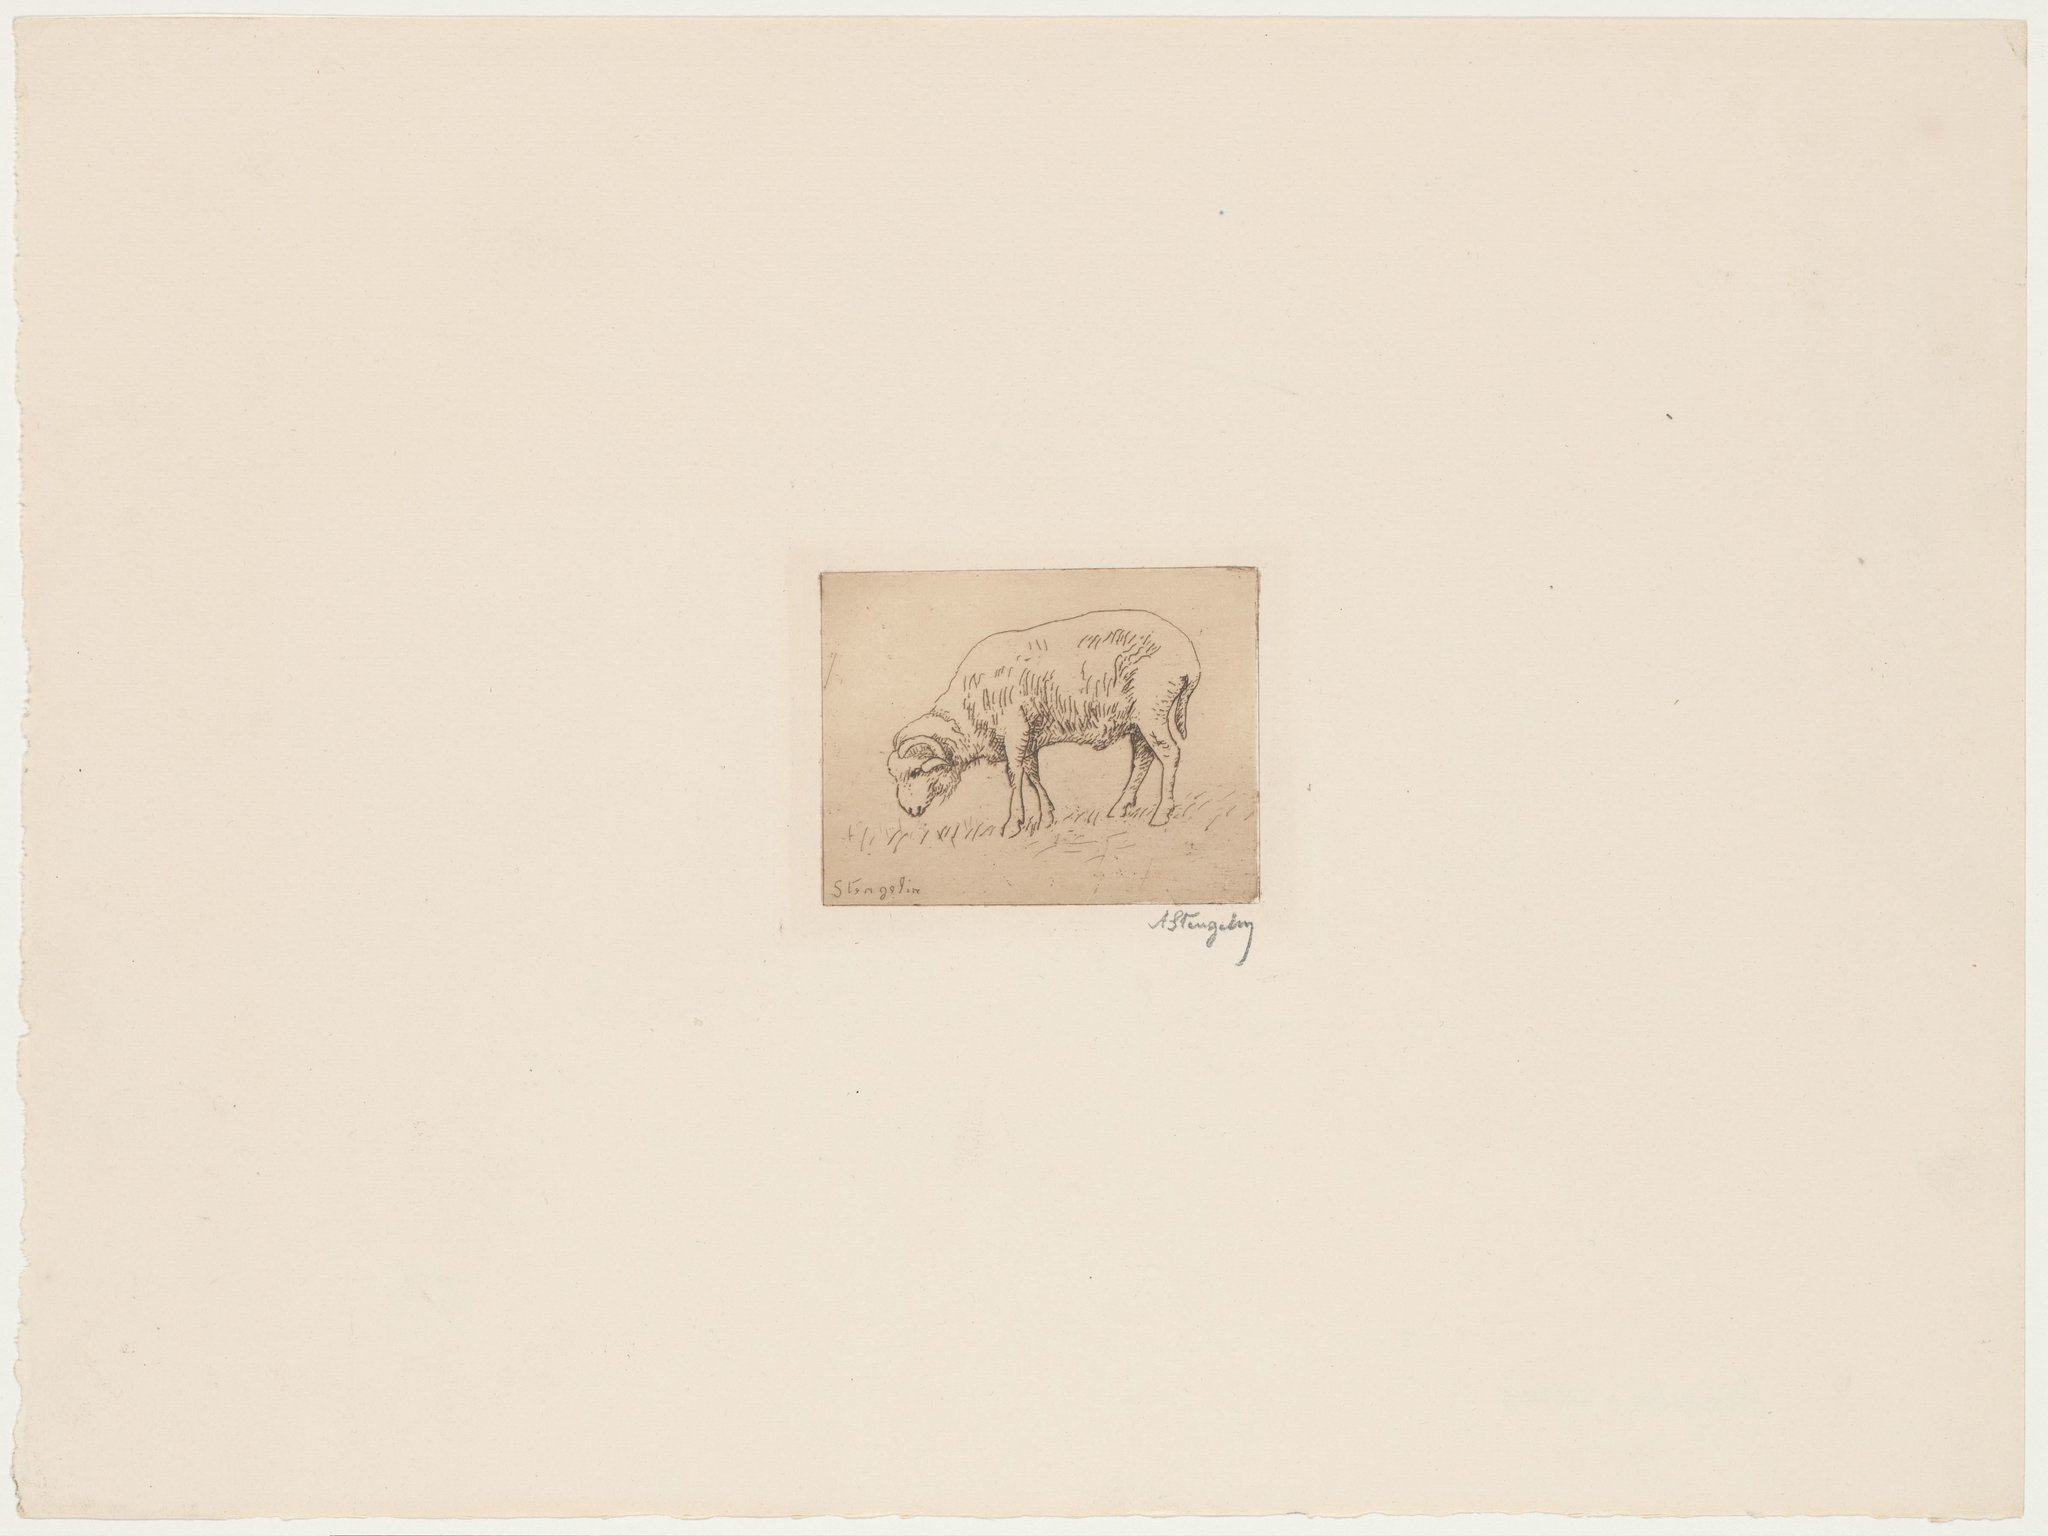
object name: print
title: Studie van een ram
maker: alphonse stengelin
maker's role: painter, print maker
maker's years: 1852-1938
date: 1862-1914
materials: paper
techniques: etching, intaglio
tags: ram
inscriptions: collector's mark: Lugt 2233